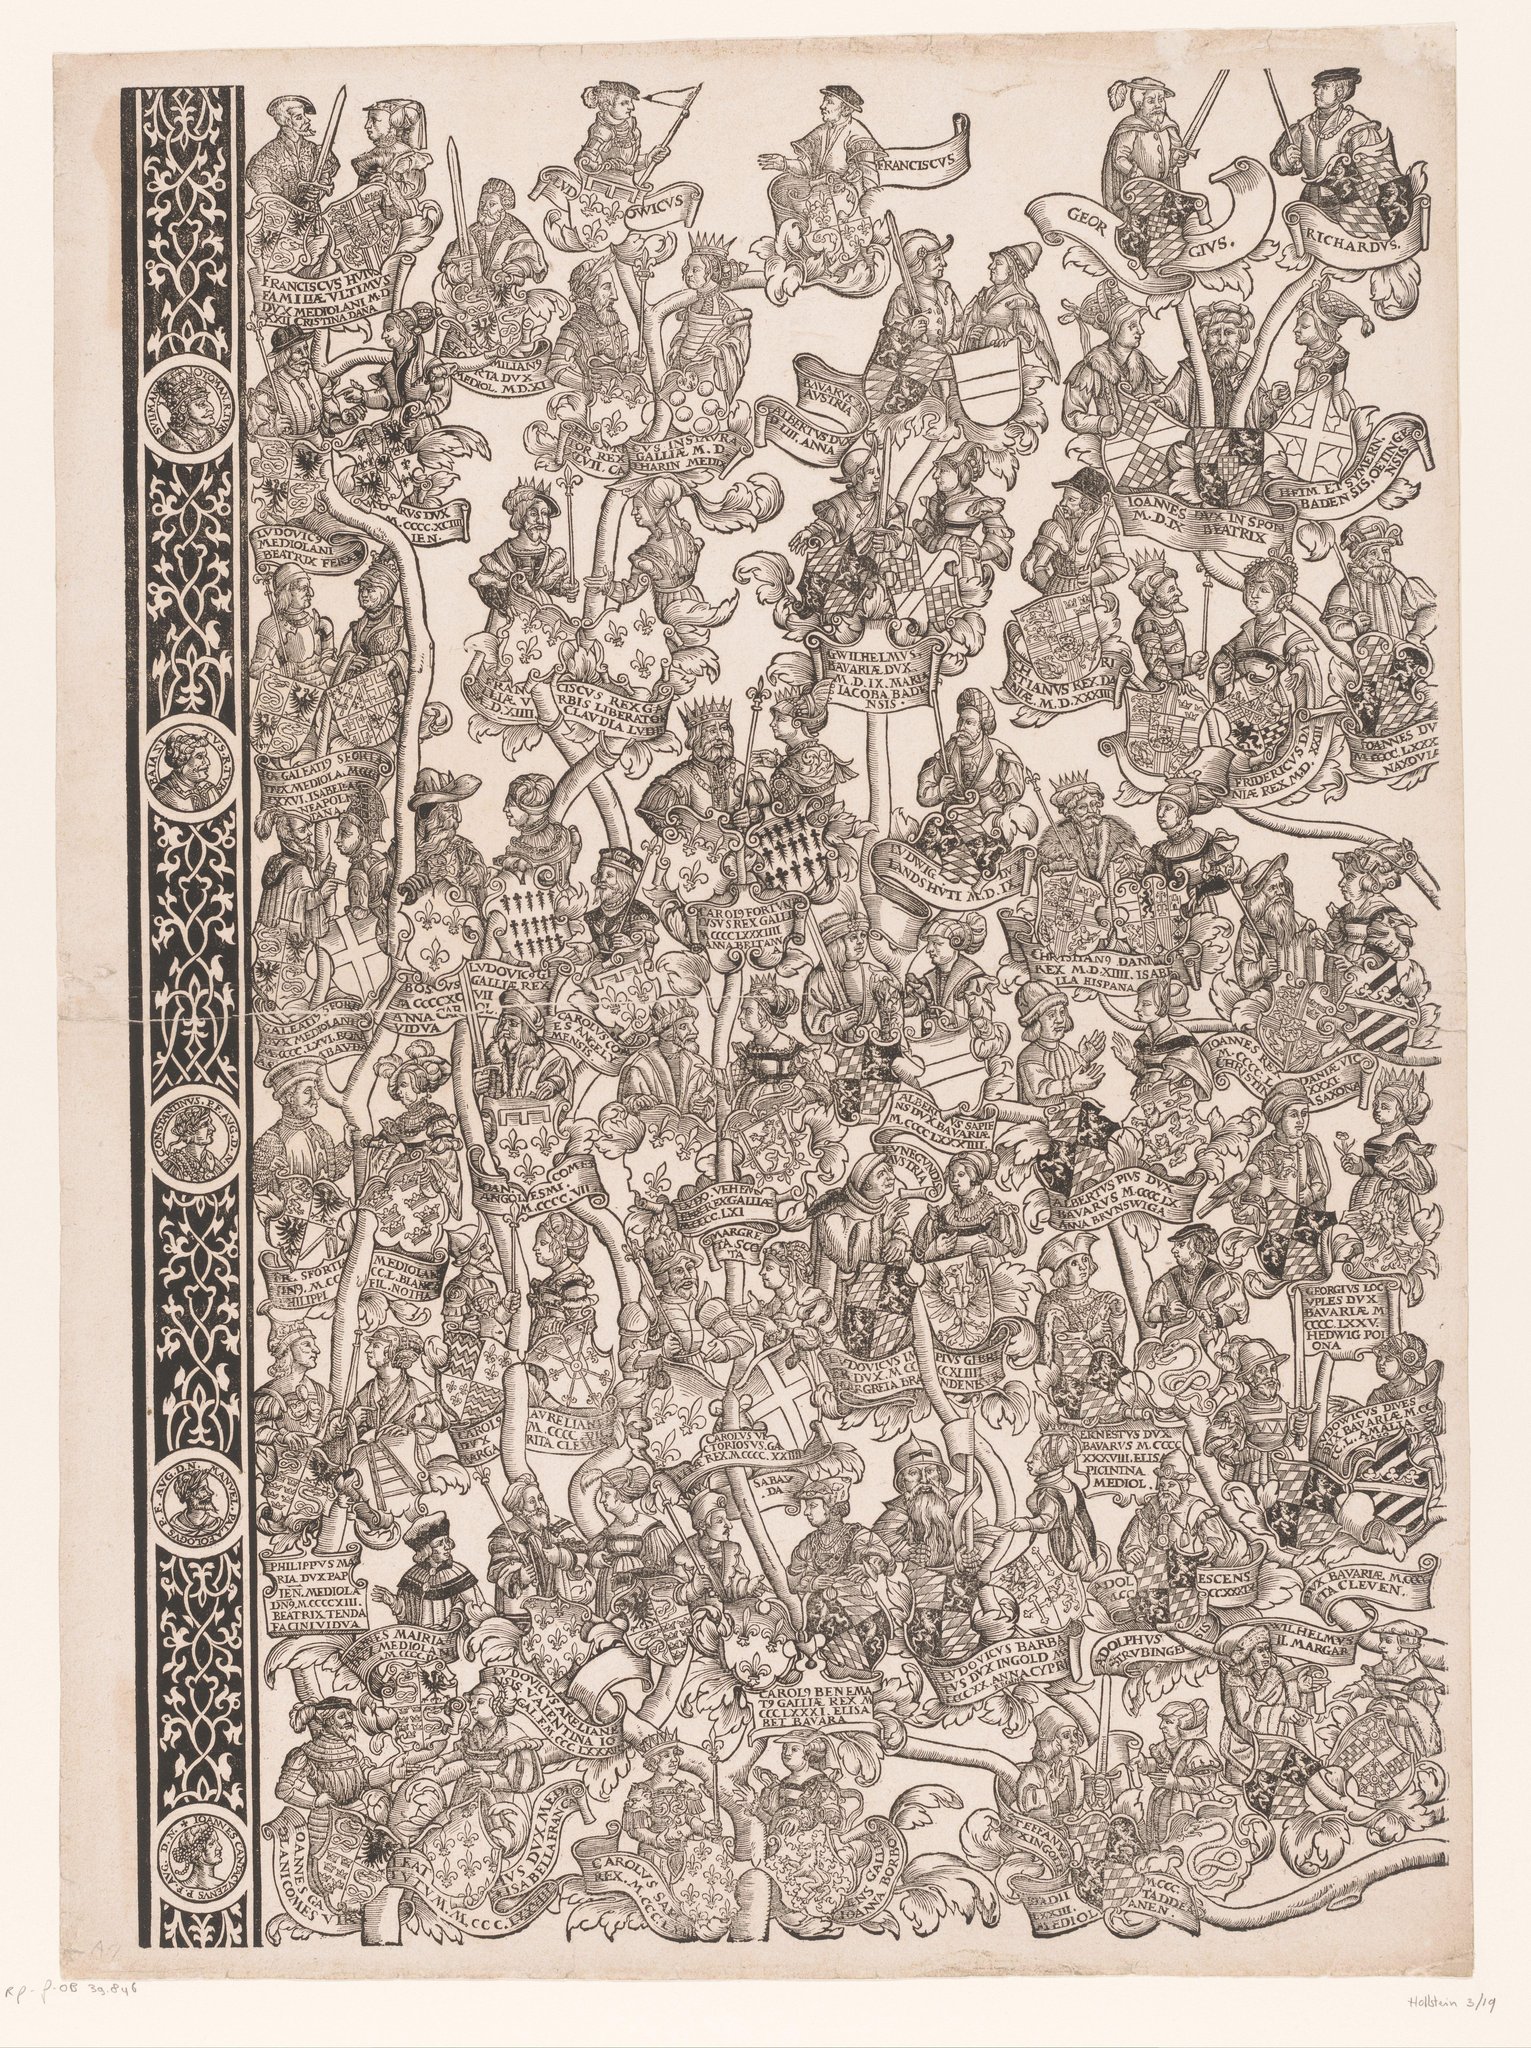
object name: print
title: Stamboom van Frederik en Ottheinrich van Palts-Neuburg (plaat 19)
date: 1535-1594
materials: paper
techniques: letterpress printing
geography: basel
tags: amberg, earl, family lineage, pedigree, genealogical tree or table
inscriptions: collector's mark: Lugt 240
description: Blad 19 van een stamboom bestaande uit 21 bladen, gedrukt van 42 blokken.